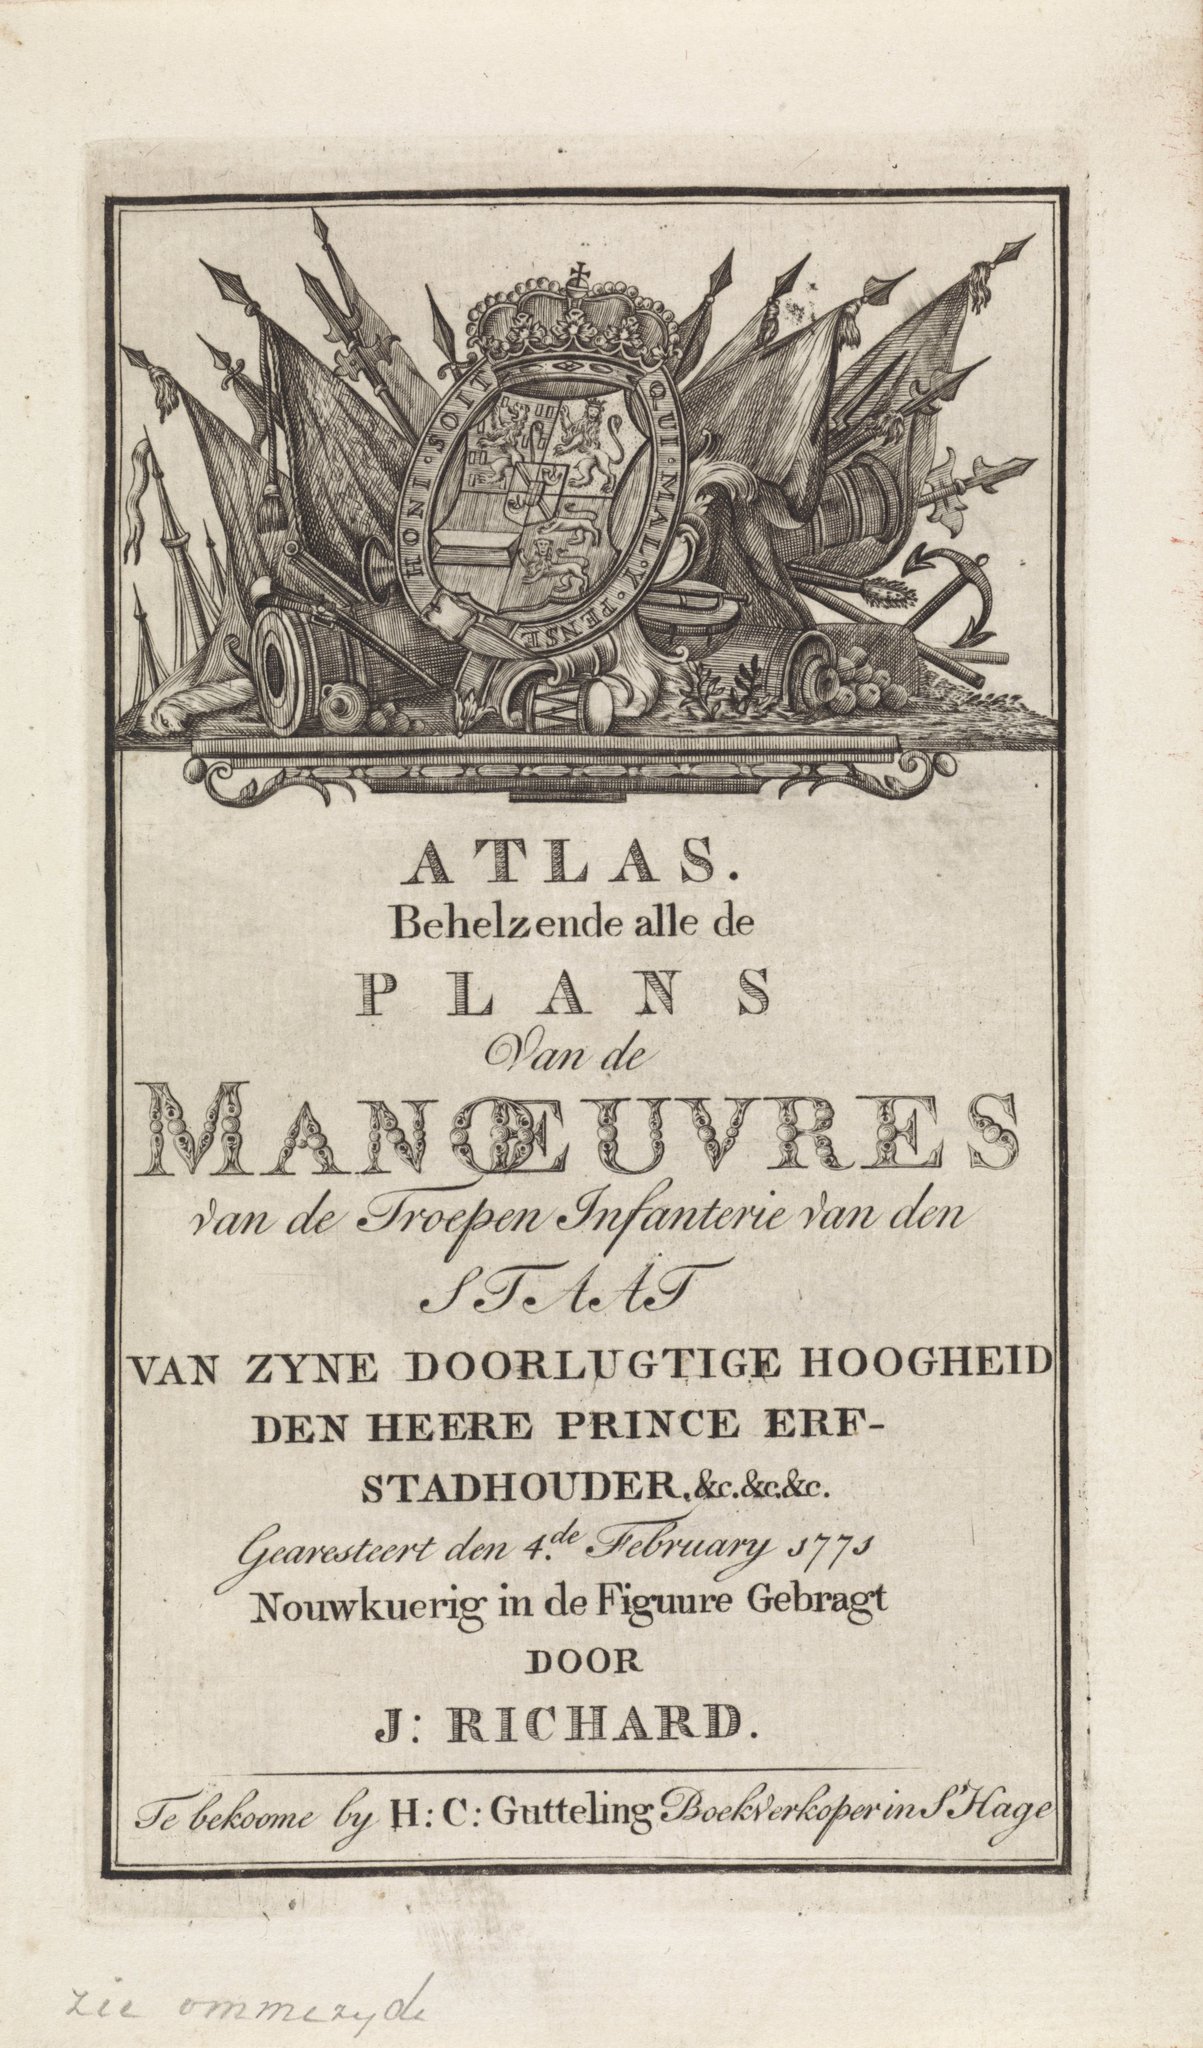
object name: titelblad, titelpagina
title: Titelpagina voor: Johannes Richard, Atlas behelzende alle de plans van de manoeuvres van de troepen infanterie (...), 1771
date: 1771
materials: paper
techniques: engraving, etching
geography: the hague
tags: william v (prince of orange), 'tropaion', i.e. decorative ornament ~ weapons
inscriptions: signature: ‘J. Richard’, collector's mark: Lugt 2228, collector's mark: Lugt 2760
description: Titelpagina voor: Richard, Johannes. Atlas behelzende alle de plans van de manœuvres van de troepen infanterie van den staat van (...) den (...) erfstadhouder (...) gearresteert den 4.de february 1771. Den Haag: Hendrik Christoffel Gutteling, 1771.